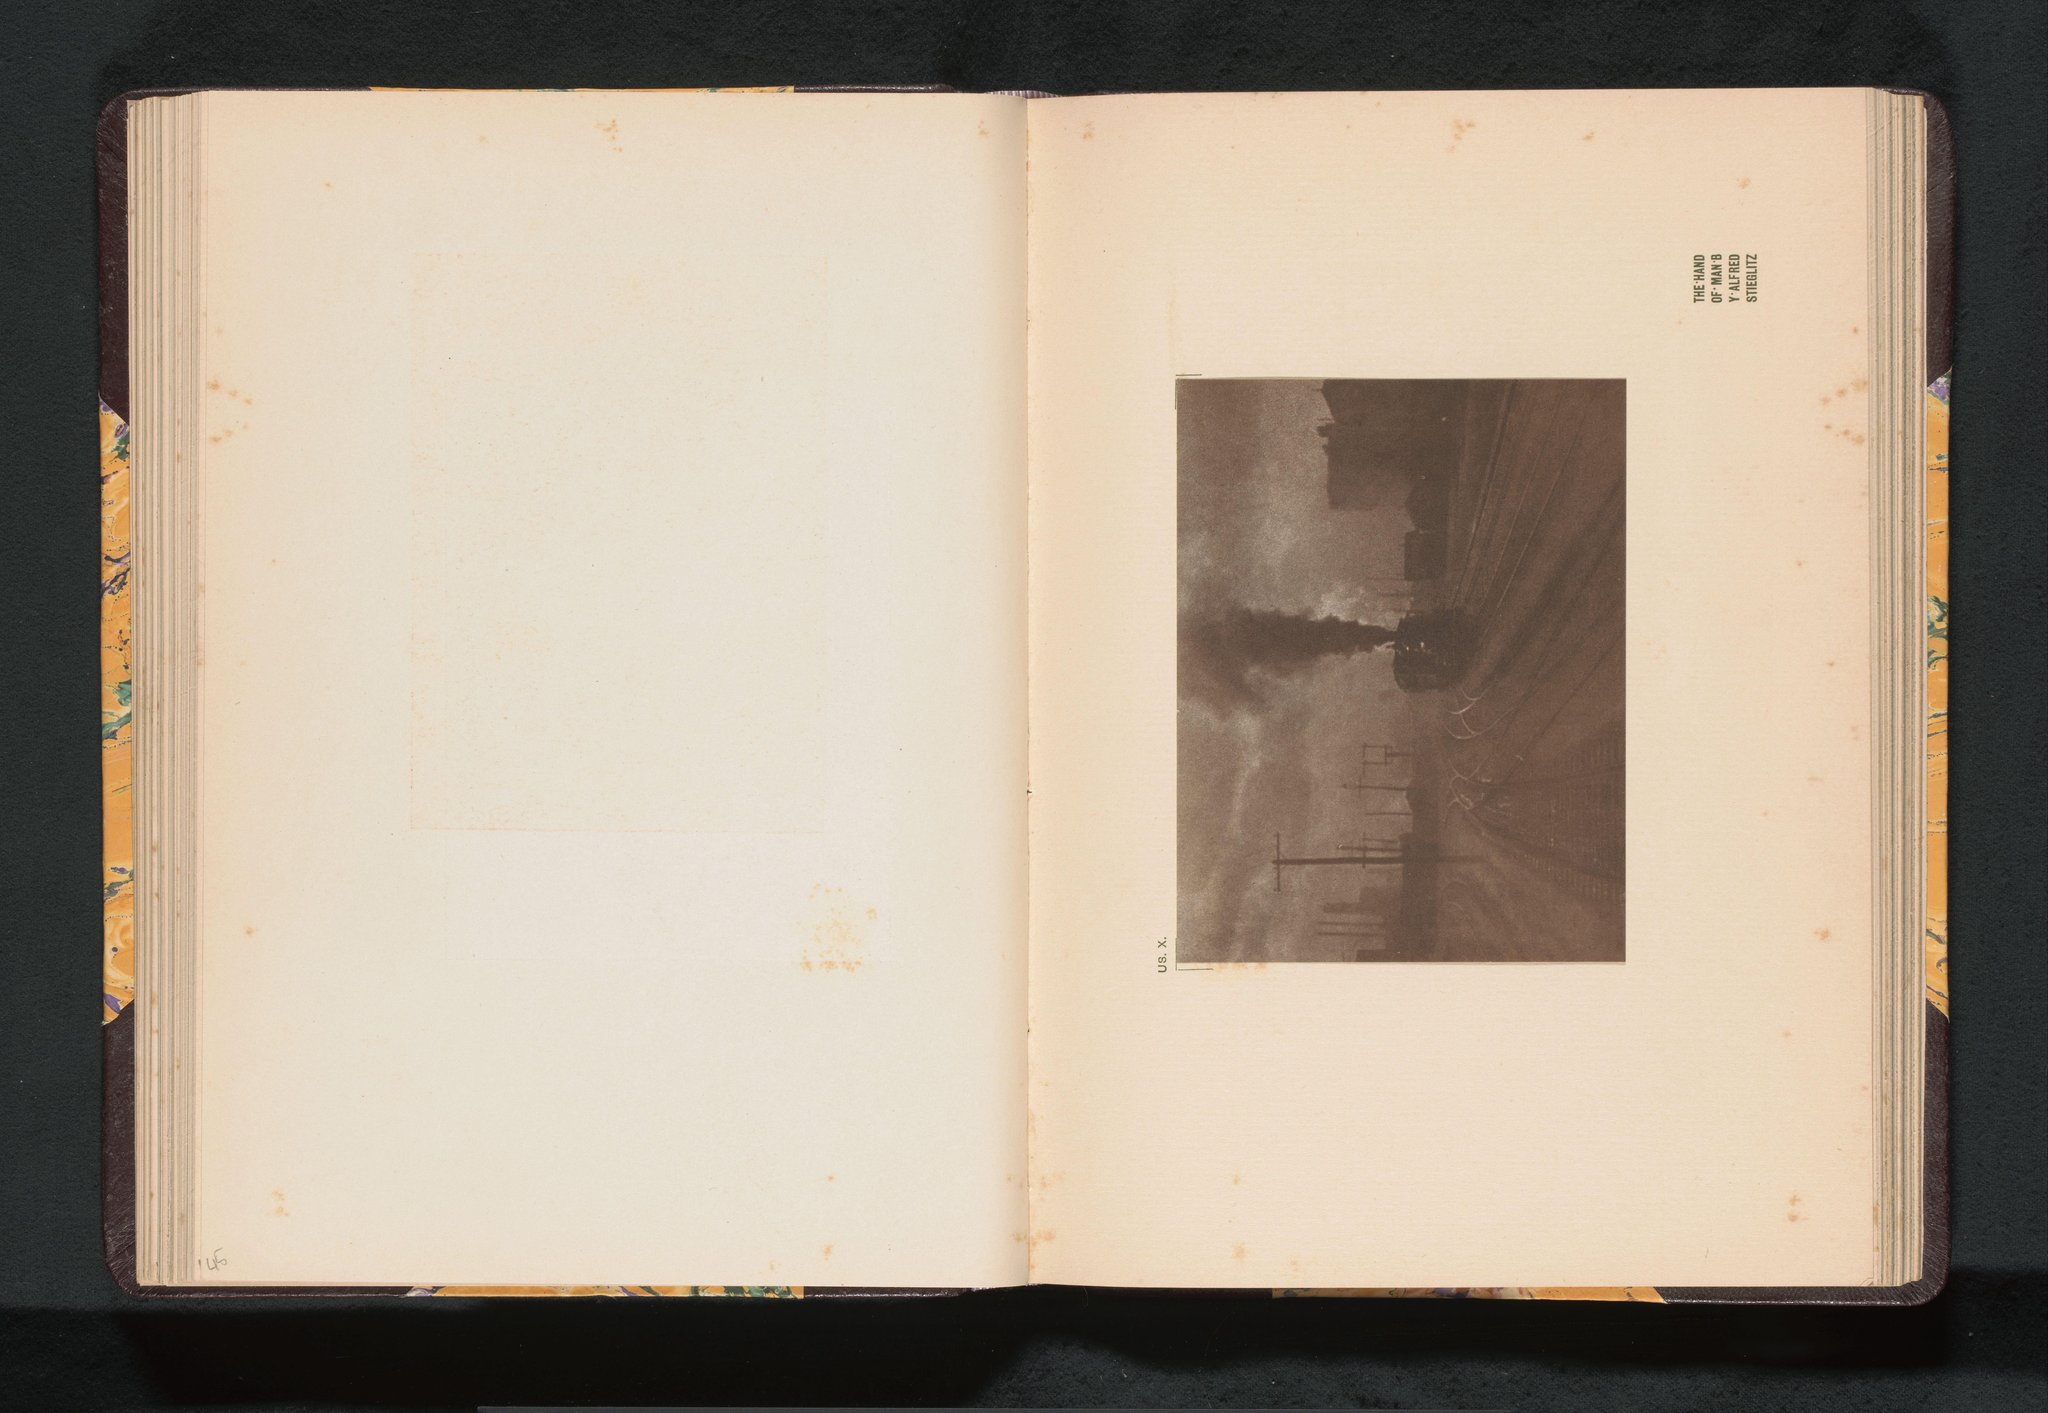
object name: photomechanical print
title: Spoorlijnen met stoomtrein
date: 1900-1905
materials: paper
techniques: two-color autotype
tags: railway, train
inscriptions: inscription: ‘US. X.’, inscription: ‘The hand of man by Alfred Stieglitz’